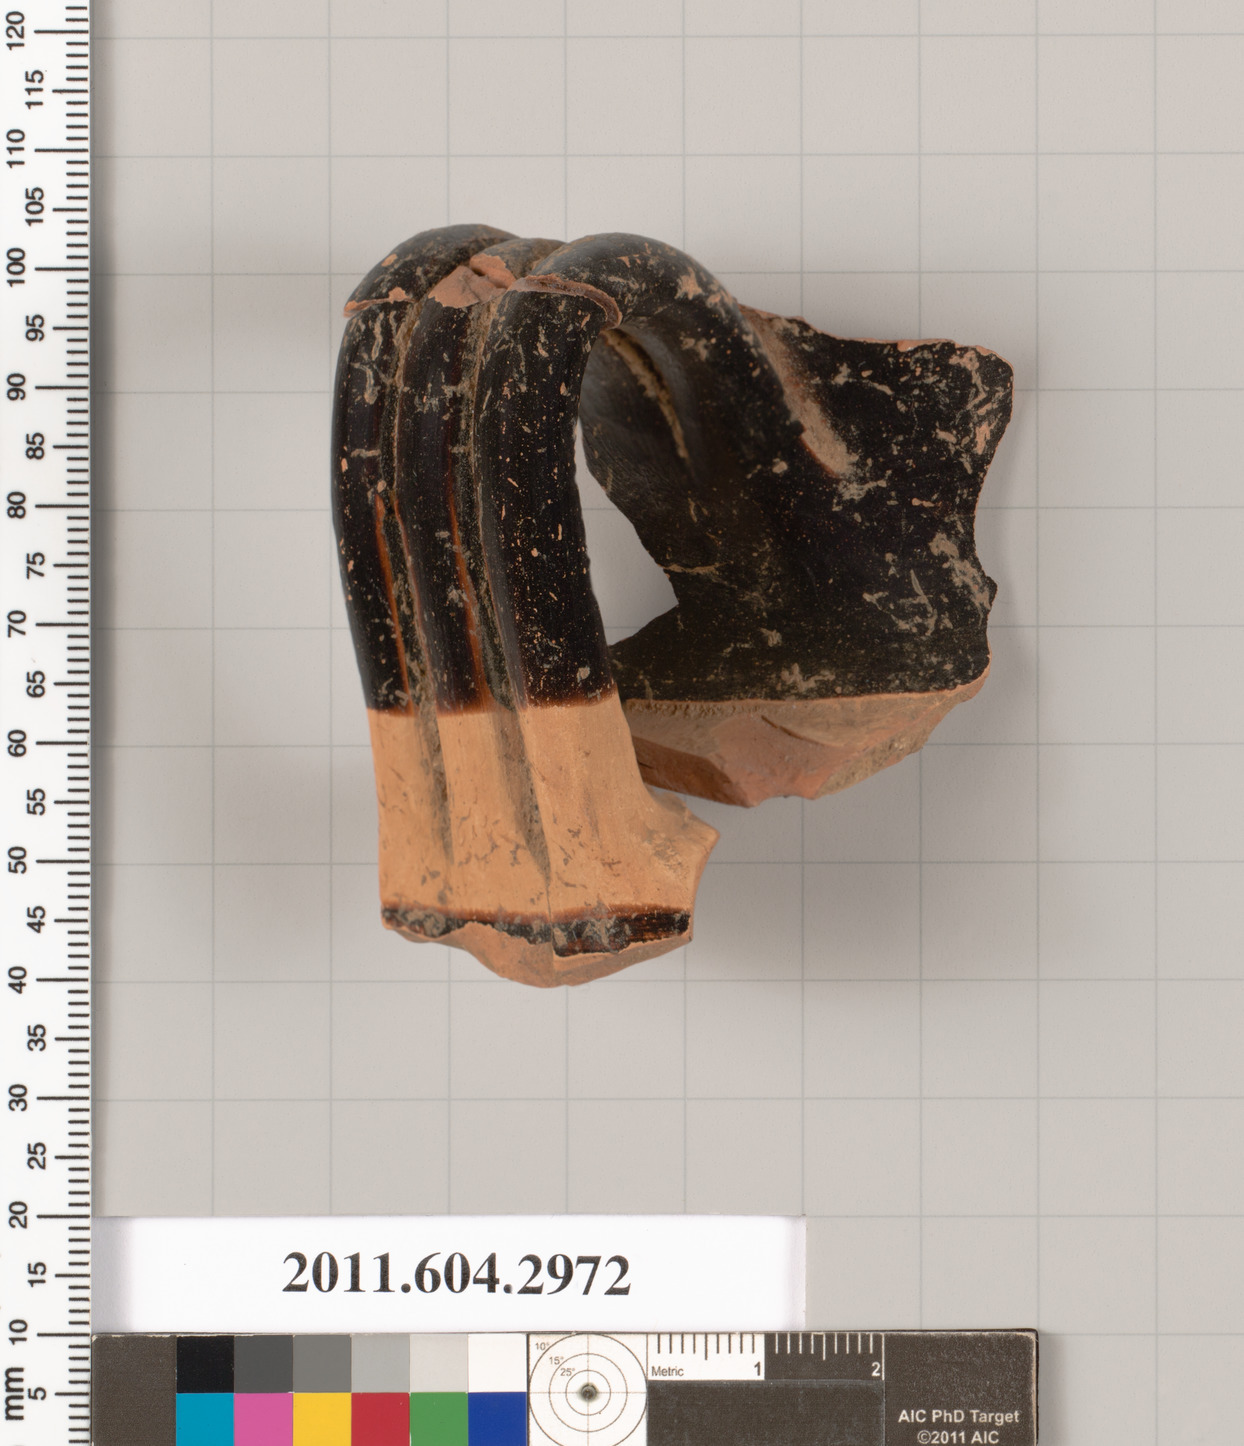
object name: oinochoe fragment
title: Terracotta fragment of an oinochoe (jug)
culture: greek, attic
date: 534-468 BCE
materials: terracotta